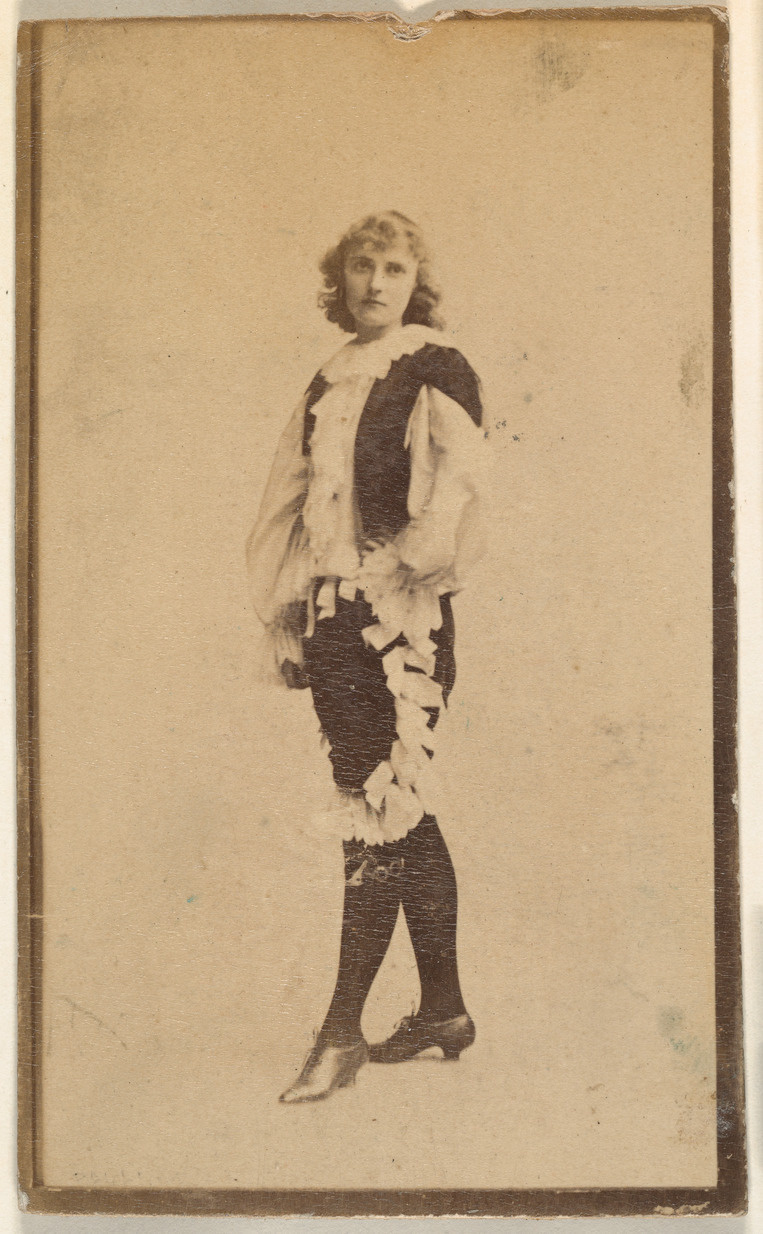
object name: photograph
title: Actress wearing costume with ruffled blouse and trousers, from the Actresses series (N668)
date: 1888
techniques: albumen silver print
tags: portraits,women,actresses